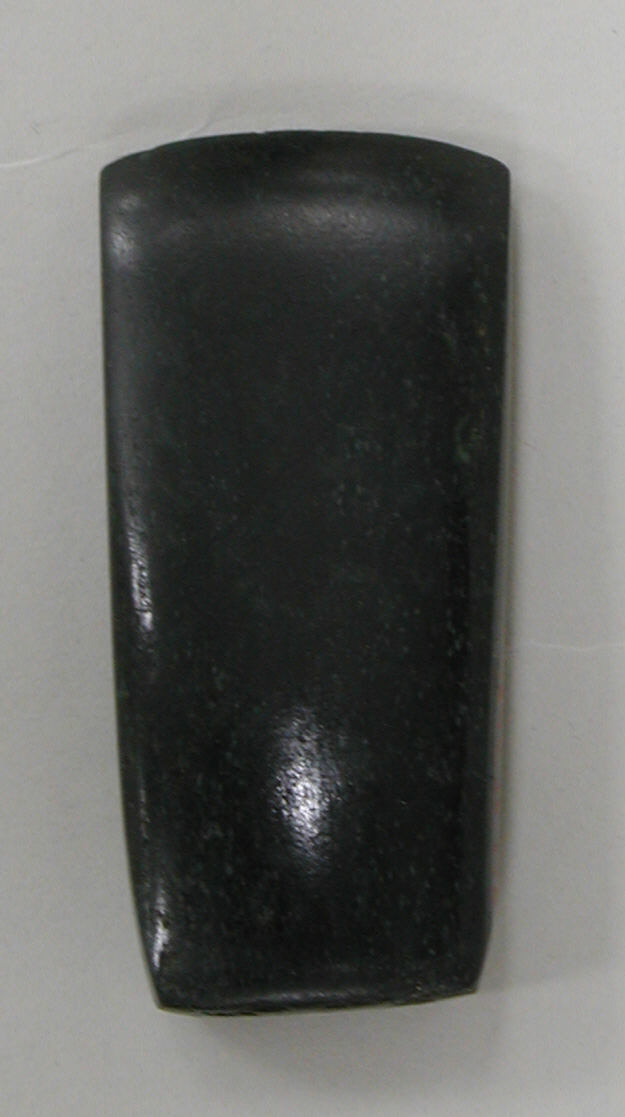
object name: chisel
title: Stone Chisel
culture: maya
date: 1501-1600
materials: stone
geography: guatemala